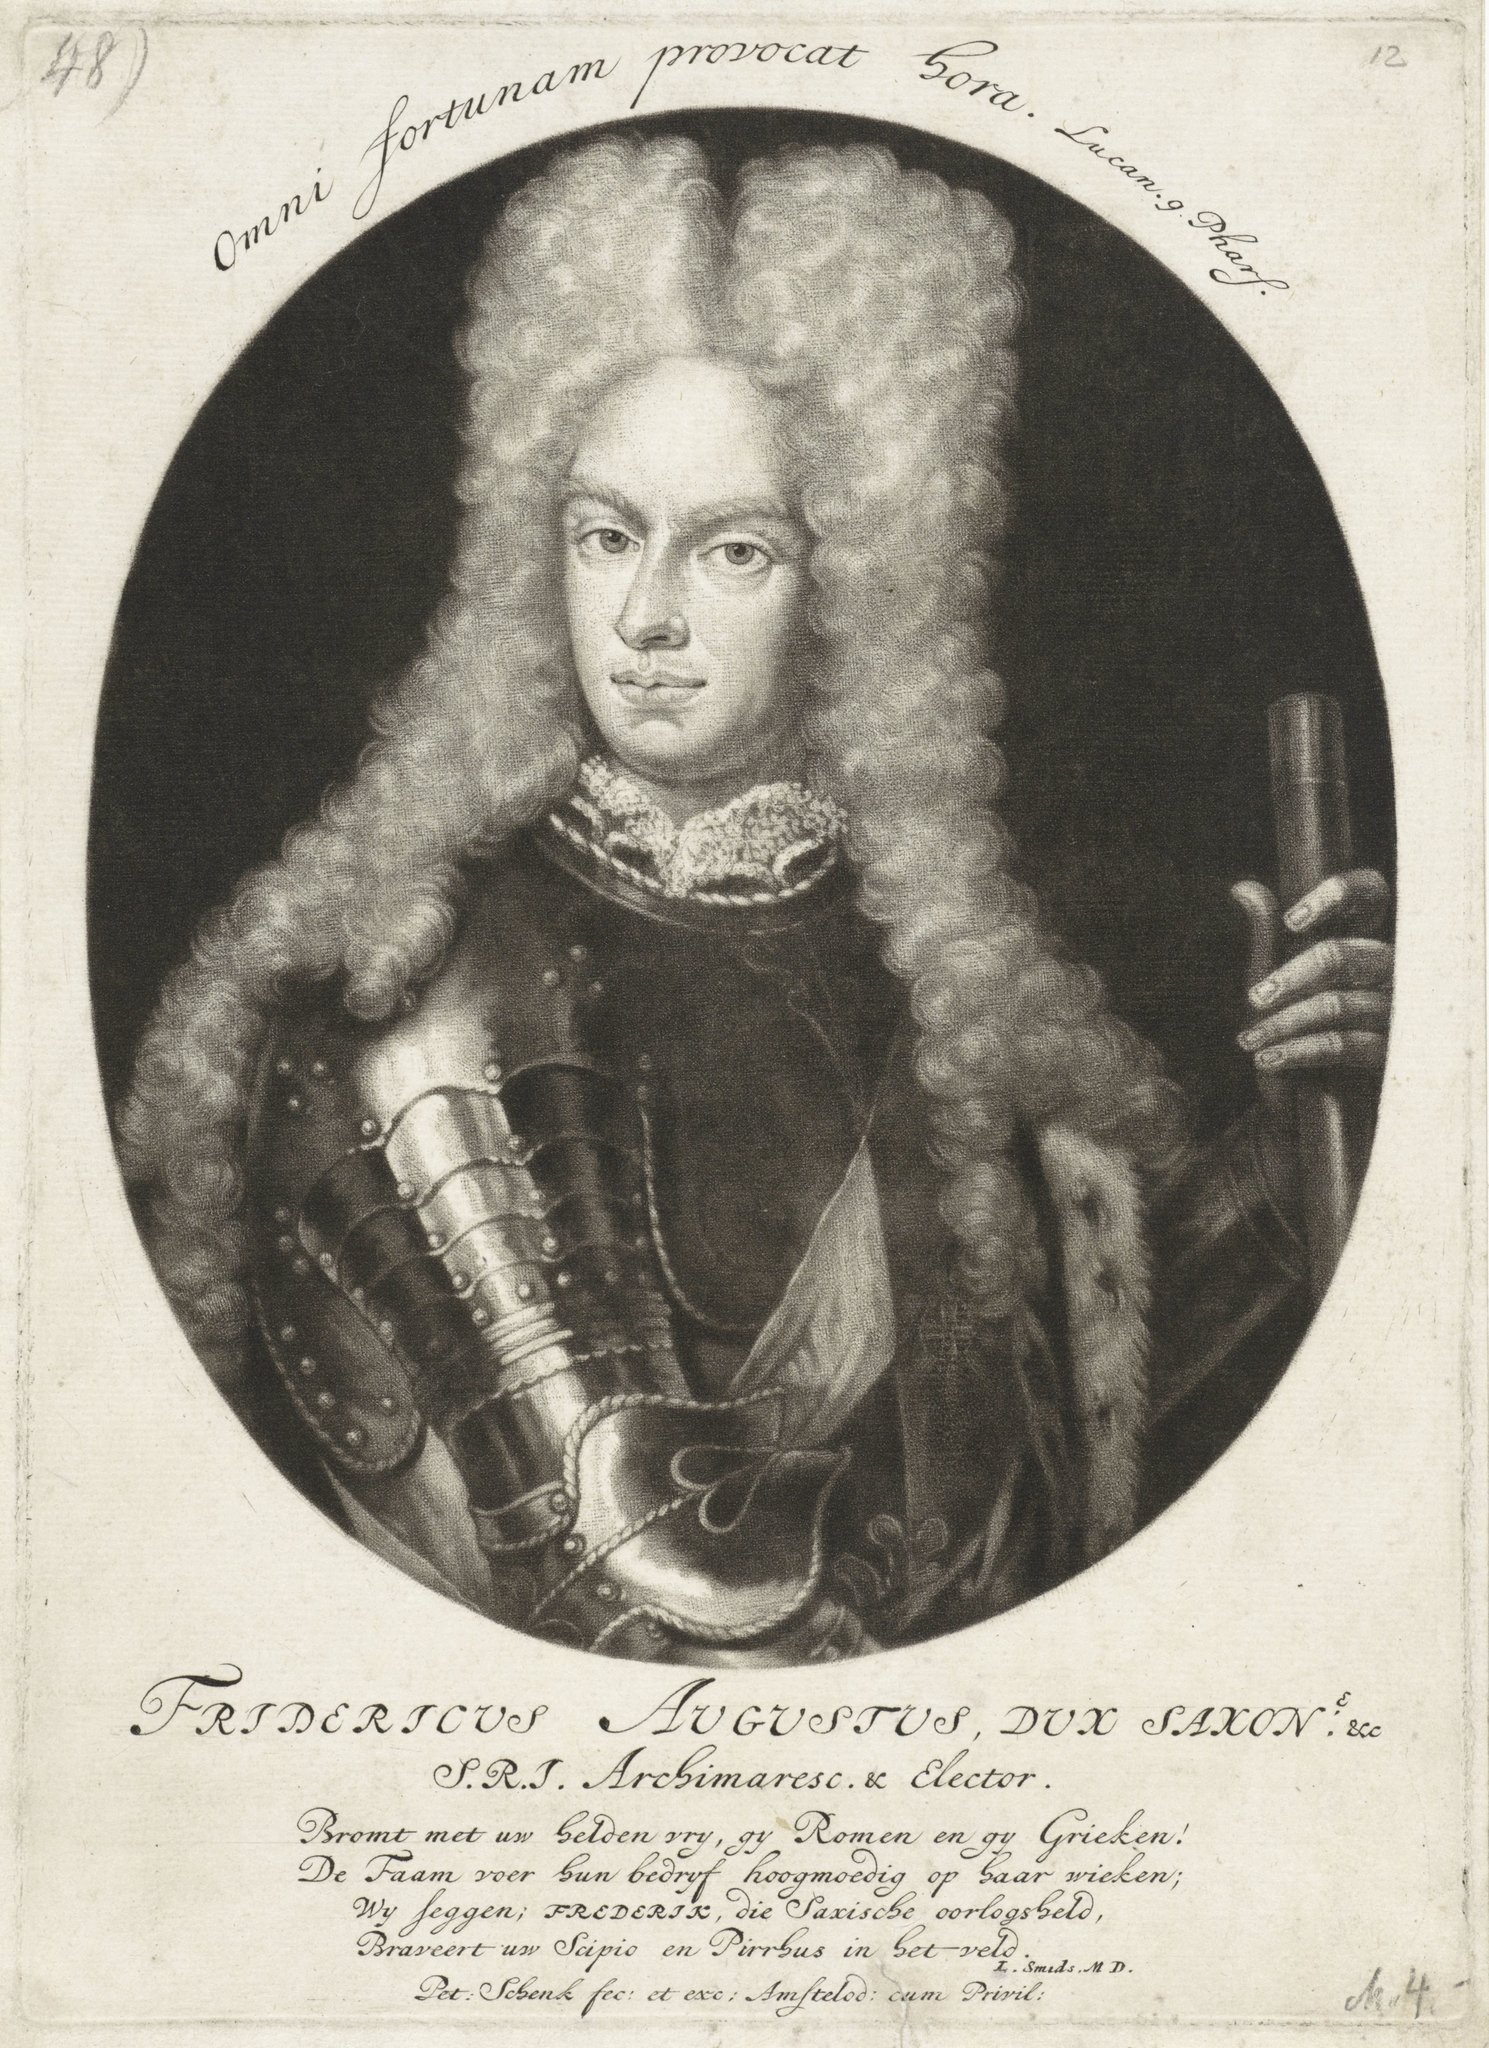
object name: print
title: Portret van Augustus II, koning van Polen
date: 1694-1713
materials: paper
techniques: engraving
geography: amsterdam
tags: august ii (king of poland), crown (symbol of sovereignty), armour, wig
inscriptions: collector's mark: Lugt 2228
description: Augustus II, keurvorst van Saksen en koning van Polen, bijgenaamd 'De Sterke'. In Saksen werd hij Frederik August I genoemd. Hij draagt een harnas en een pruik.